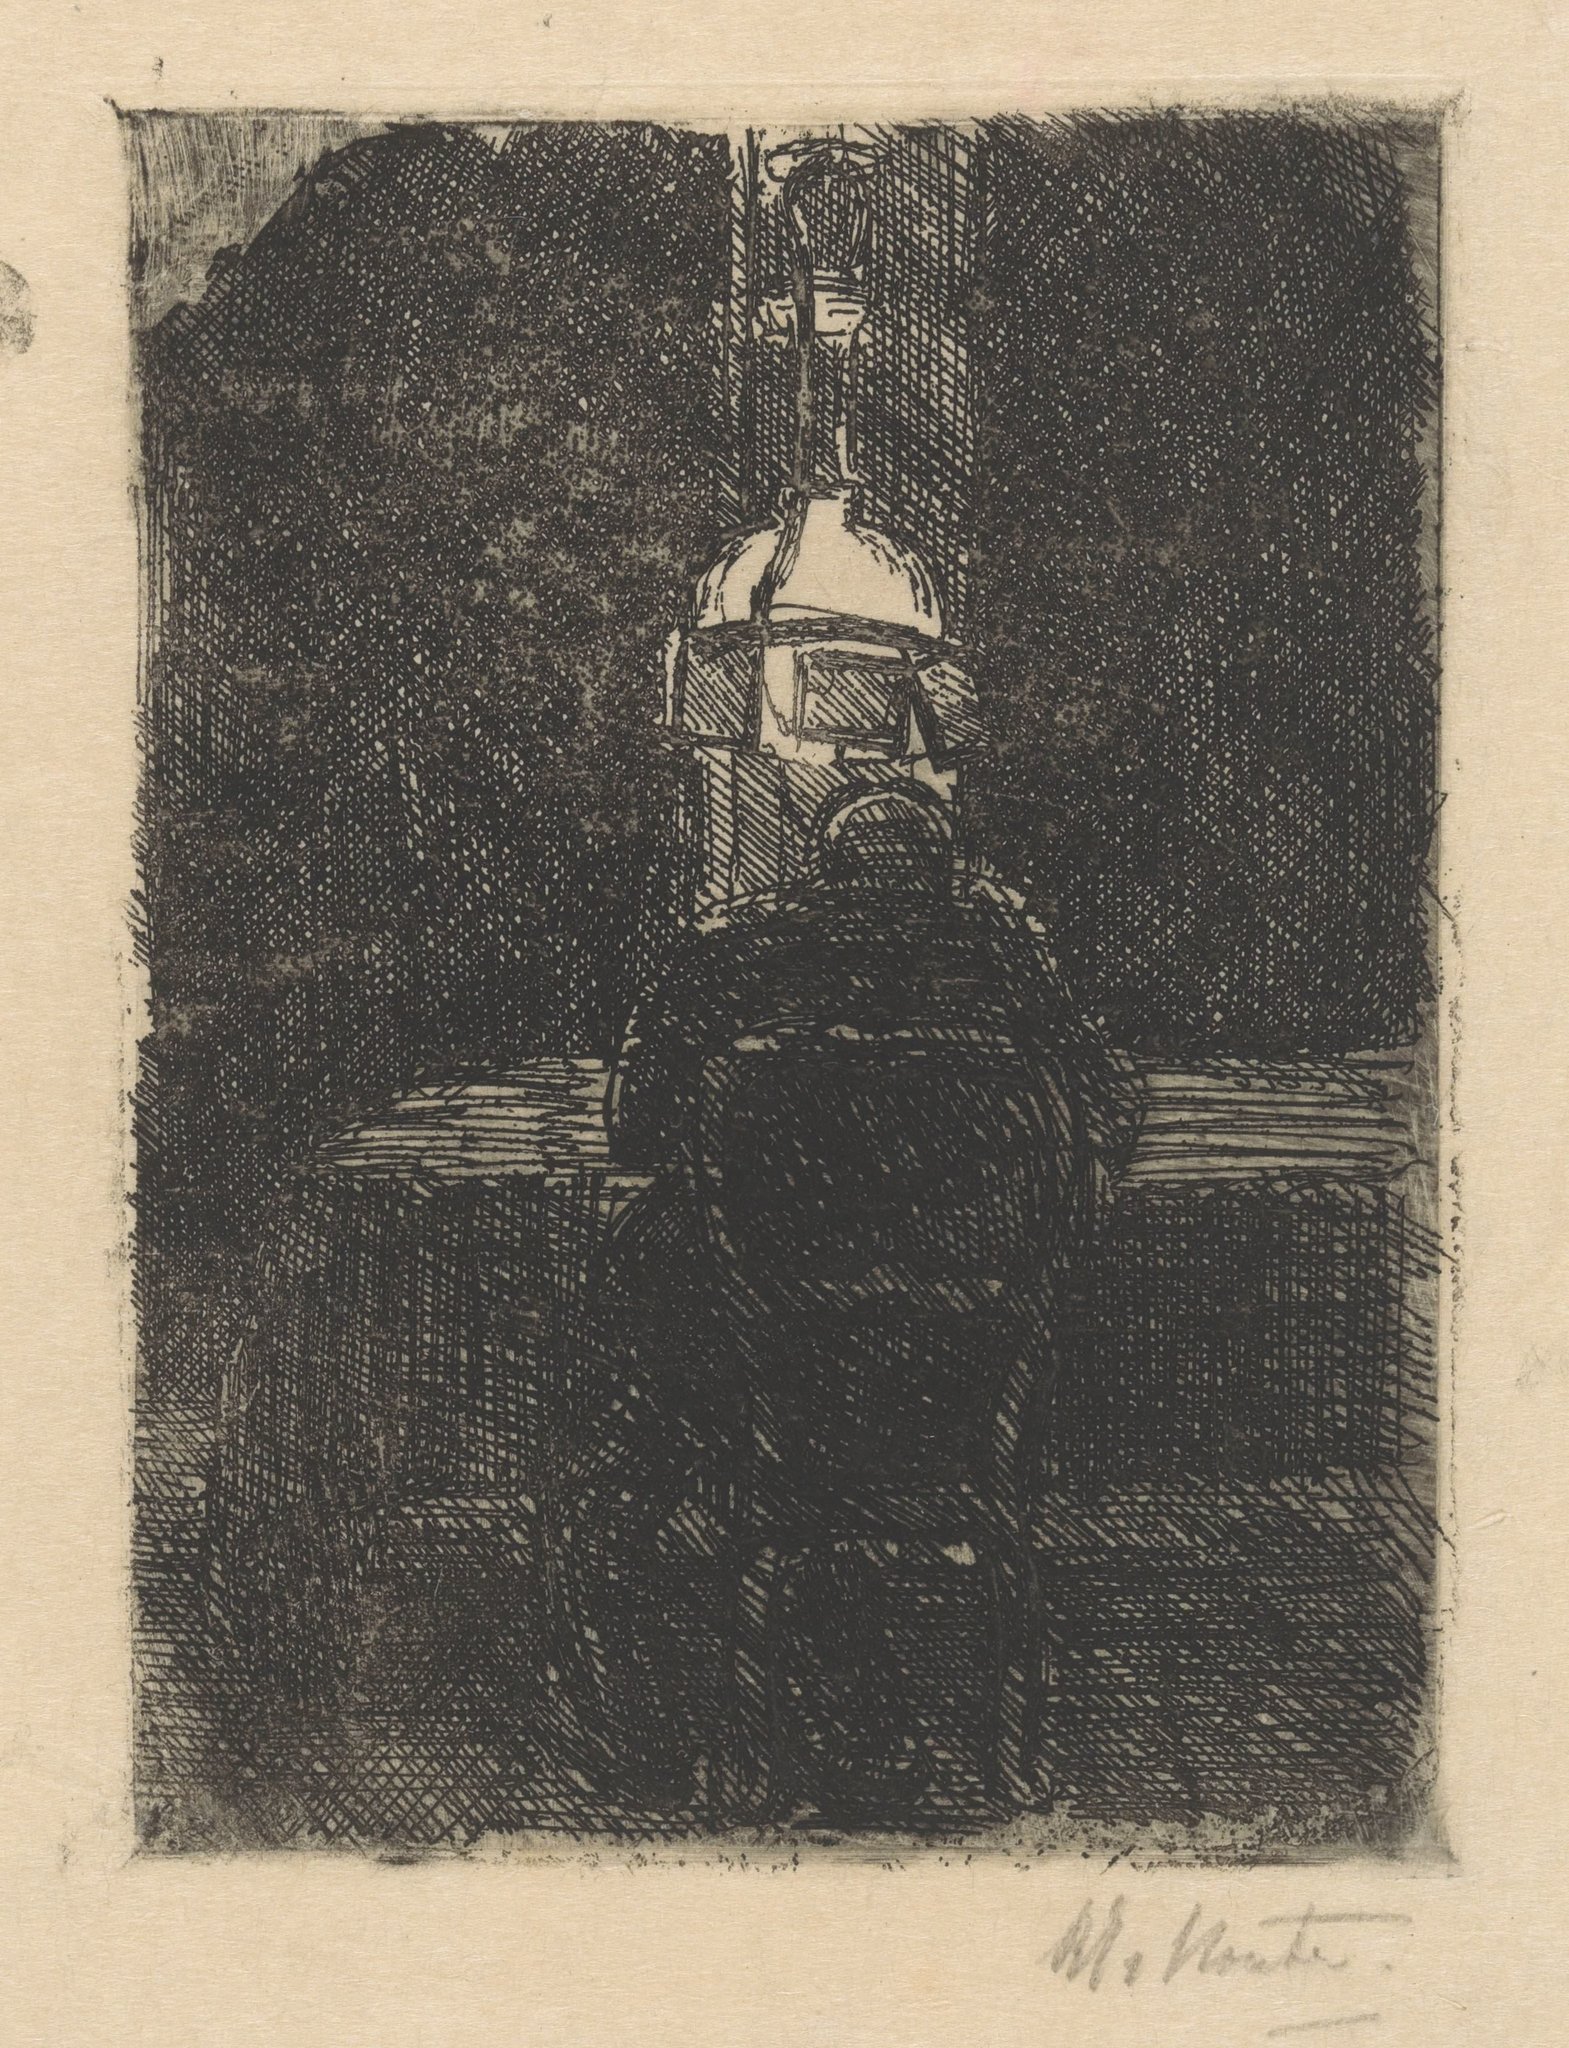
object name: print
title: Sientje Mesdag-van Houten aan tafel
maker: barbara elisabeth van houten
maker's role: draughtsman, print maker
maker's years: 1862-1950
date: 1877-1950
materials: paper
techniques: etching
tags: the hague, painter, draughtsman, sientje mesdag-van houten, reading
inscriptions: collector's mark: Lugt 2228